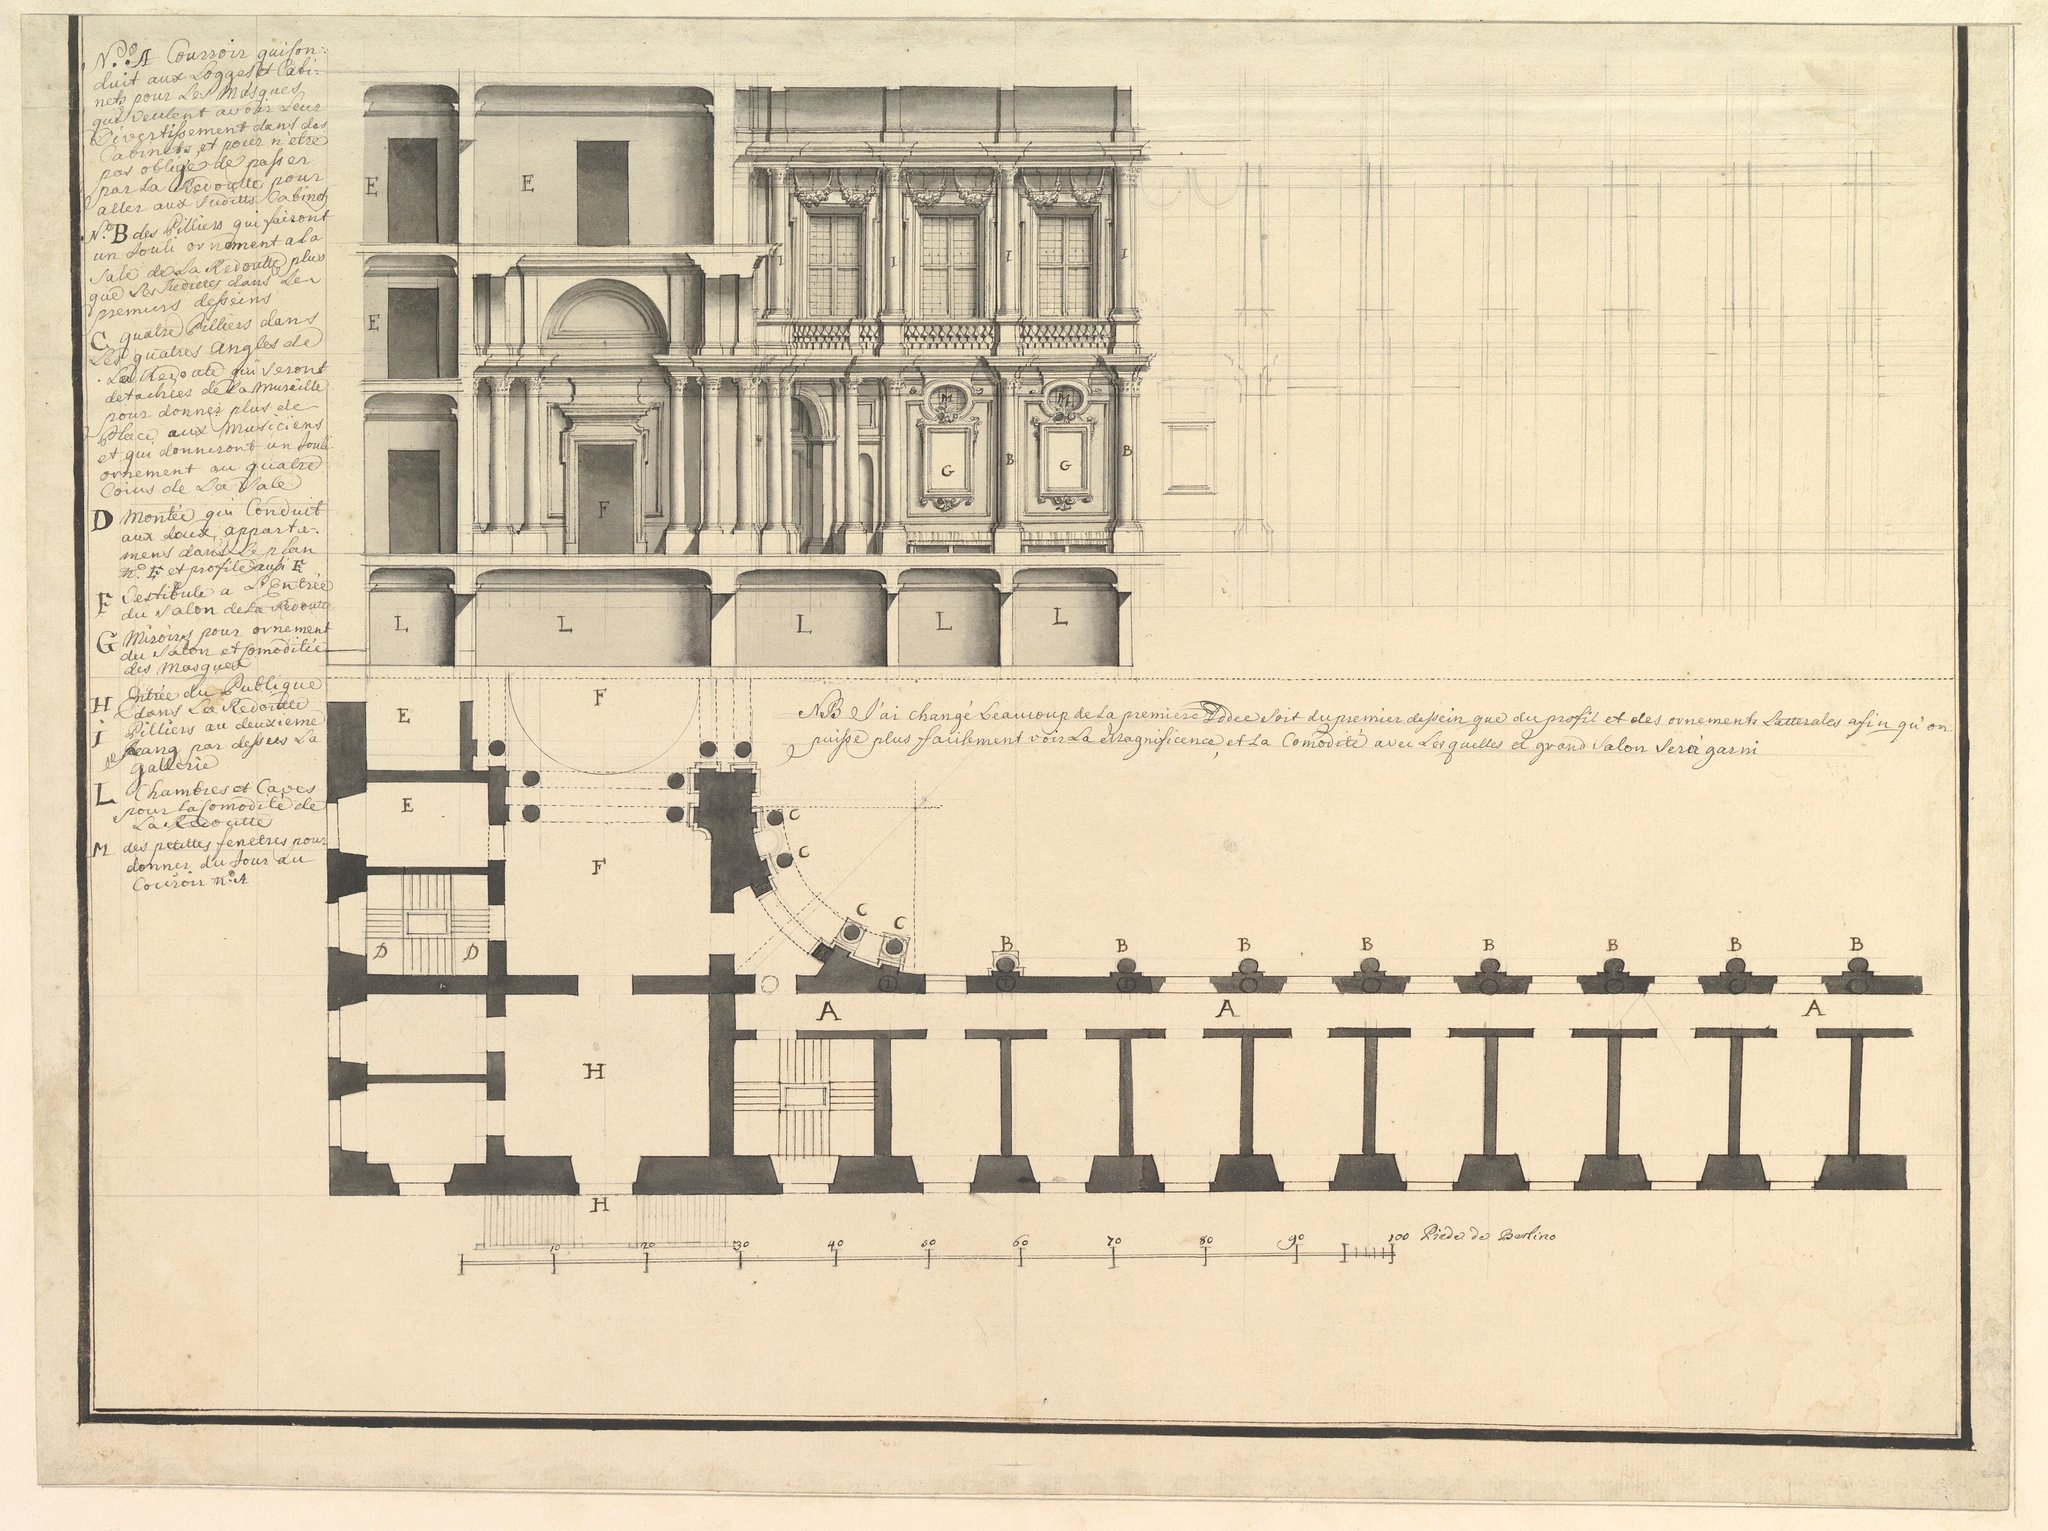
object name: drawing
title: Half Longitudinal Section and Half Plan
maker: giuseppe galli bibiena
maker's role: artist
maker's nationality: italian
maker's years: 1696-1756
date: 1750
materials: ink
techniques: pen, wash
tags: buildings